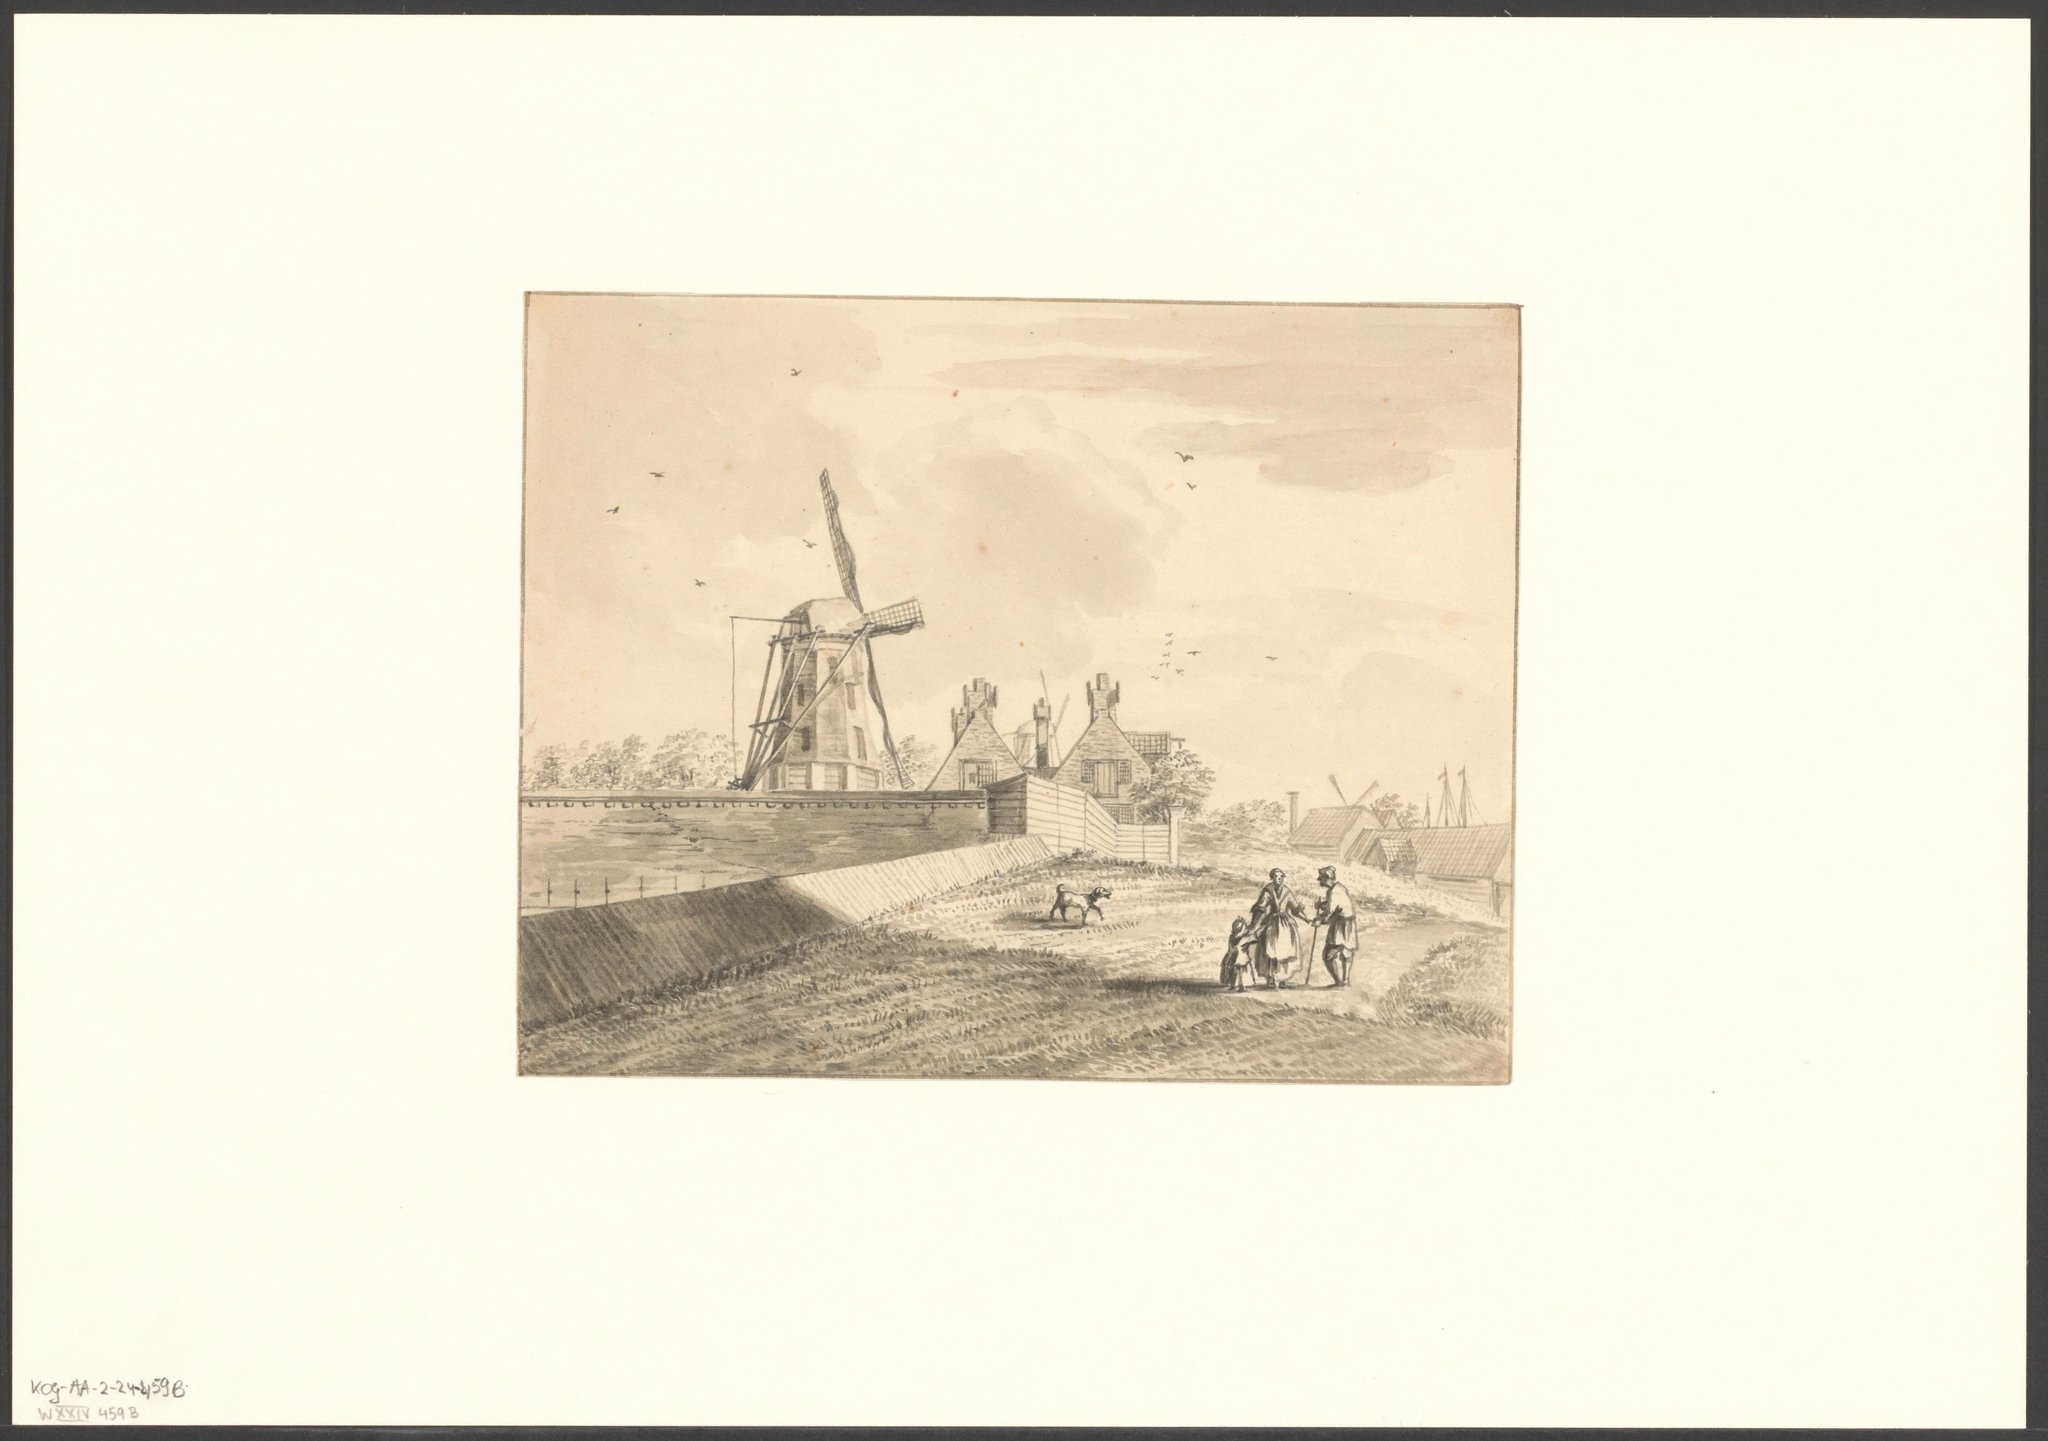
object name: drawing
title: Gezicht op bolwerk Nieuwkerk met molen Het Roode Hart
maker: bartholomeus barbiers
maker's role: draughtsman, painter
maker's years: 1740-1808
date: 1753-1808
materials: ink, paper, pencil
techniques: brush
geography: amsterdam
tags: city-view in general; 'veduta', windmill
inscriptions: inscription: ‘de Molen de Steenbok aan de Elandsstraat / op de schans van de Molen, destar (?) te zien. / de groote stinkmolens Bolwerk Nieuwkerk’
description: Tekening binnen de Atlas Van Eck ingedeeld op wijknummer 24.